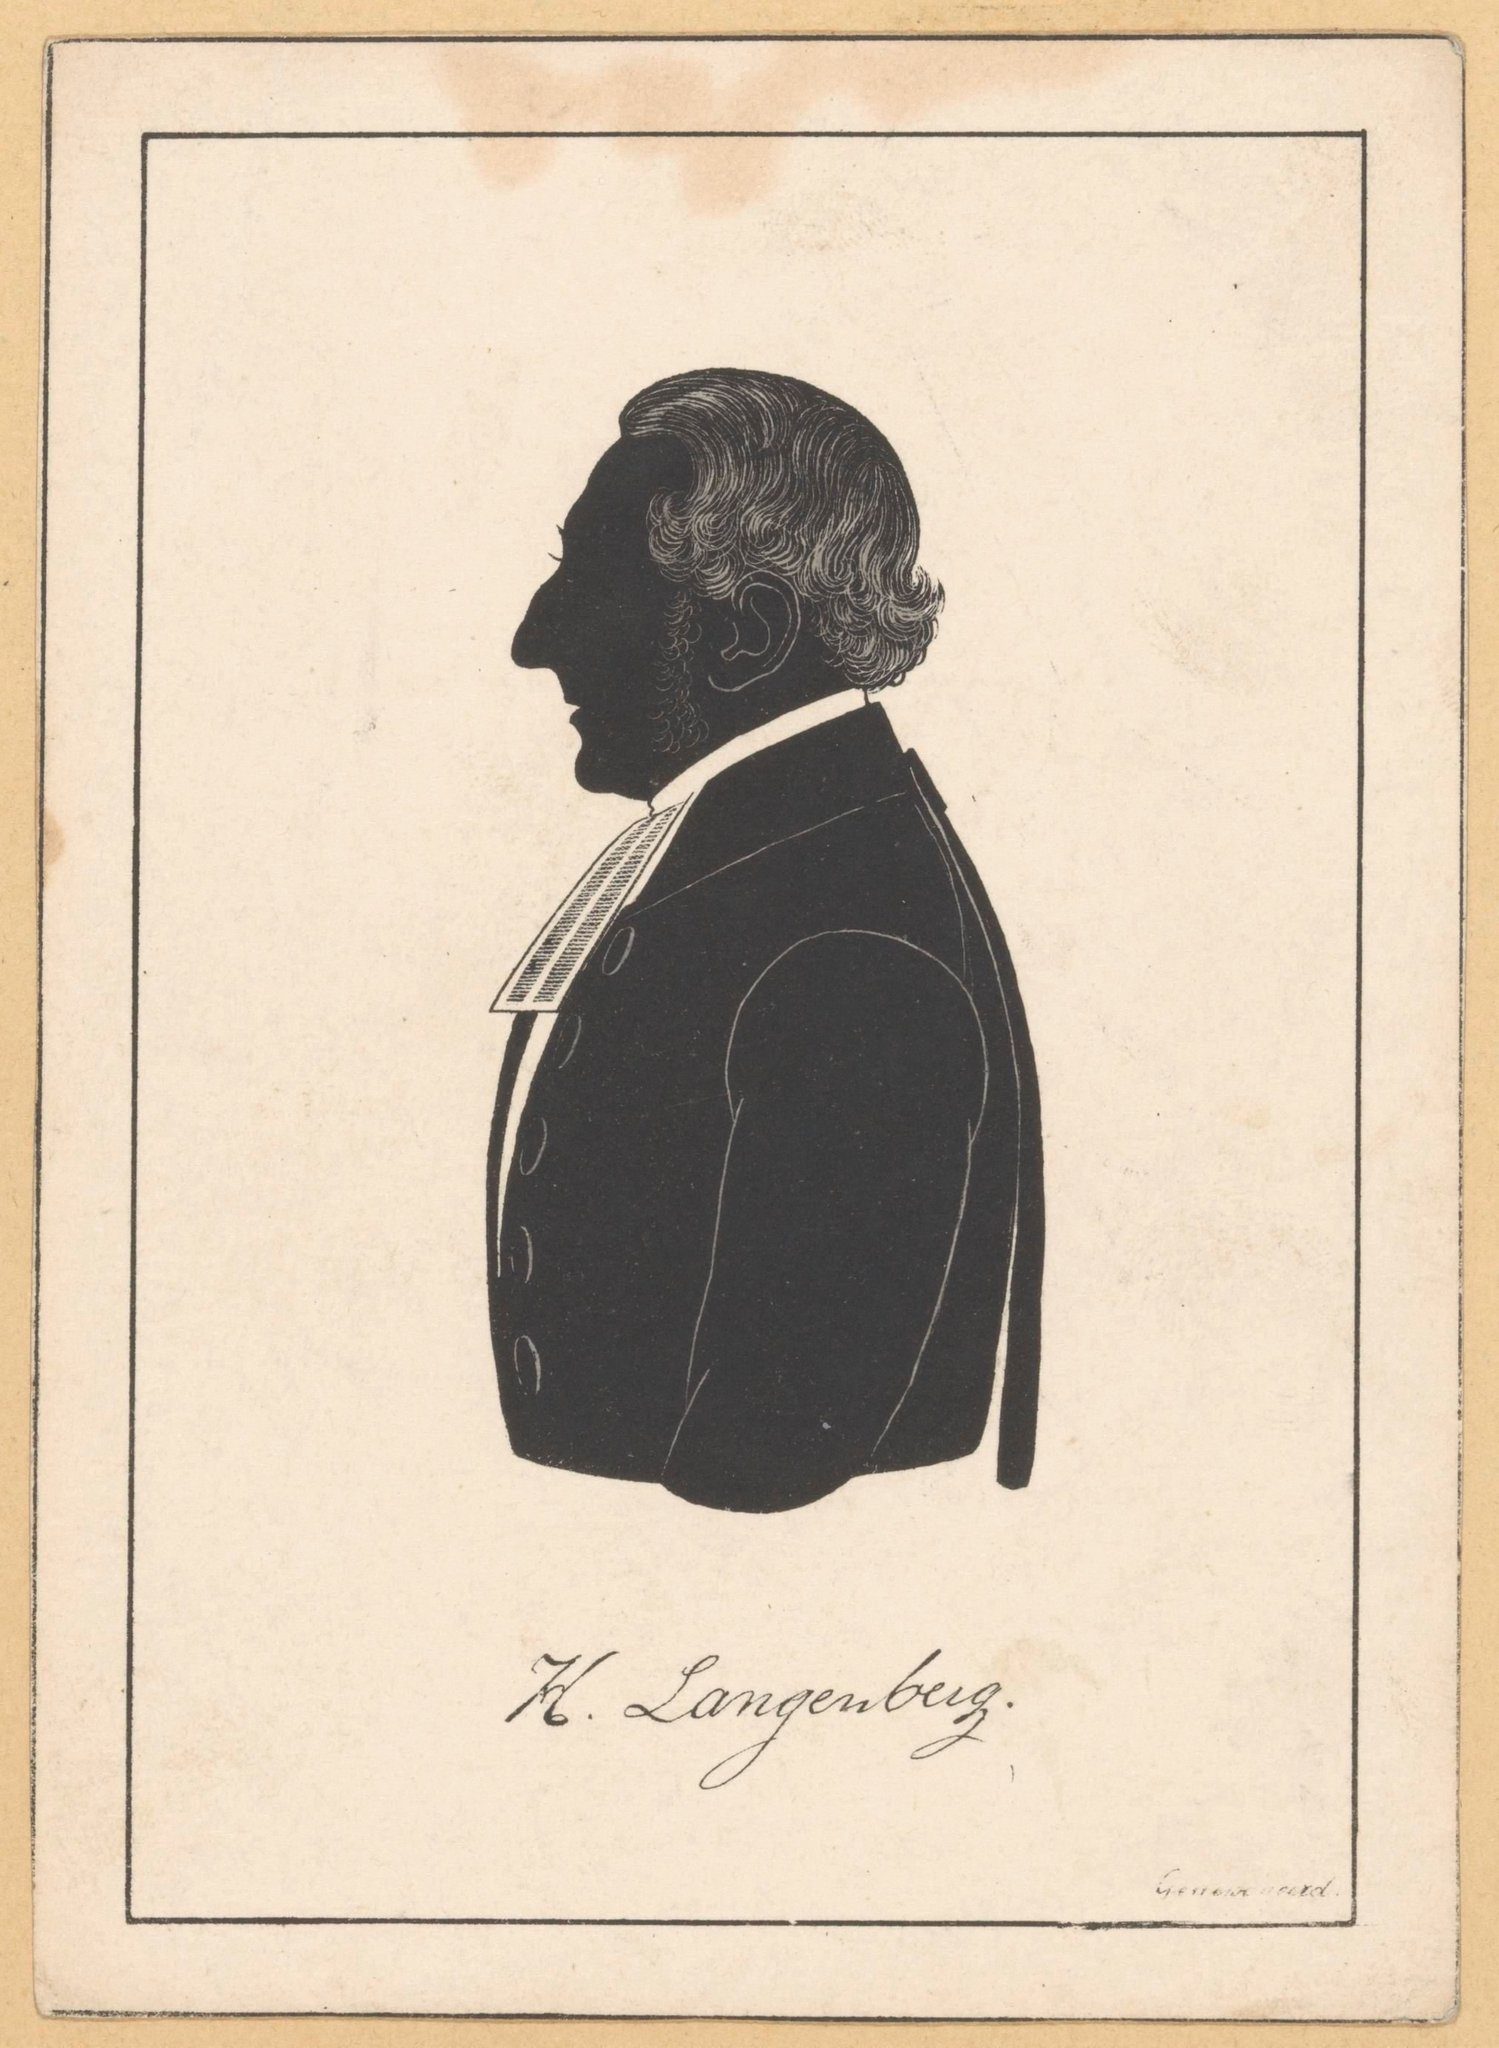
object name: print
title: Silhouetportret van Hendrik Langenberg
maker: pieter barbiers (iv)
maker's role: painter, print maker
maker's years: 1798-1848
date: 1809-1848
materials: paper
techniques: hand coloring, lithograph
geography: netherlands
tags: historical persons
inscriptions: collector's mark: Lugt 2228, : ‘Gedeponeerd.’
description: Onder het portret de signatuur van de geportretteerde.